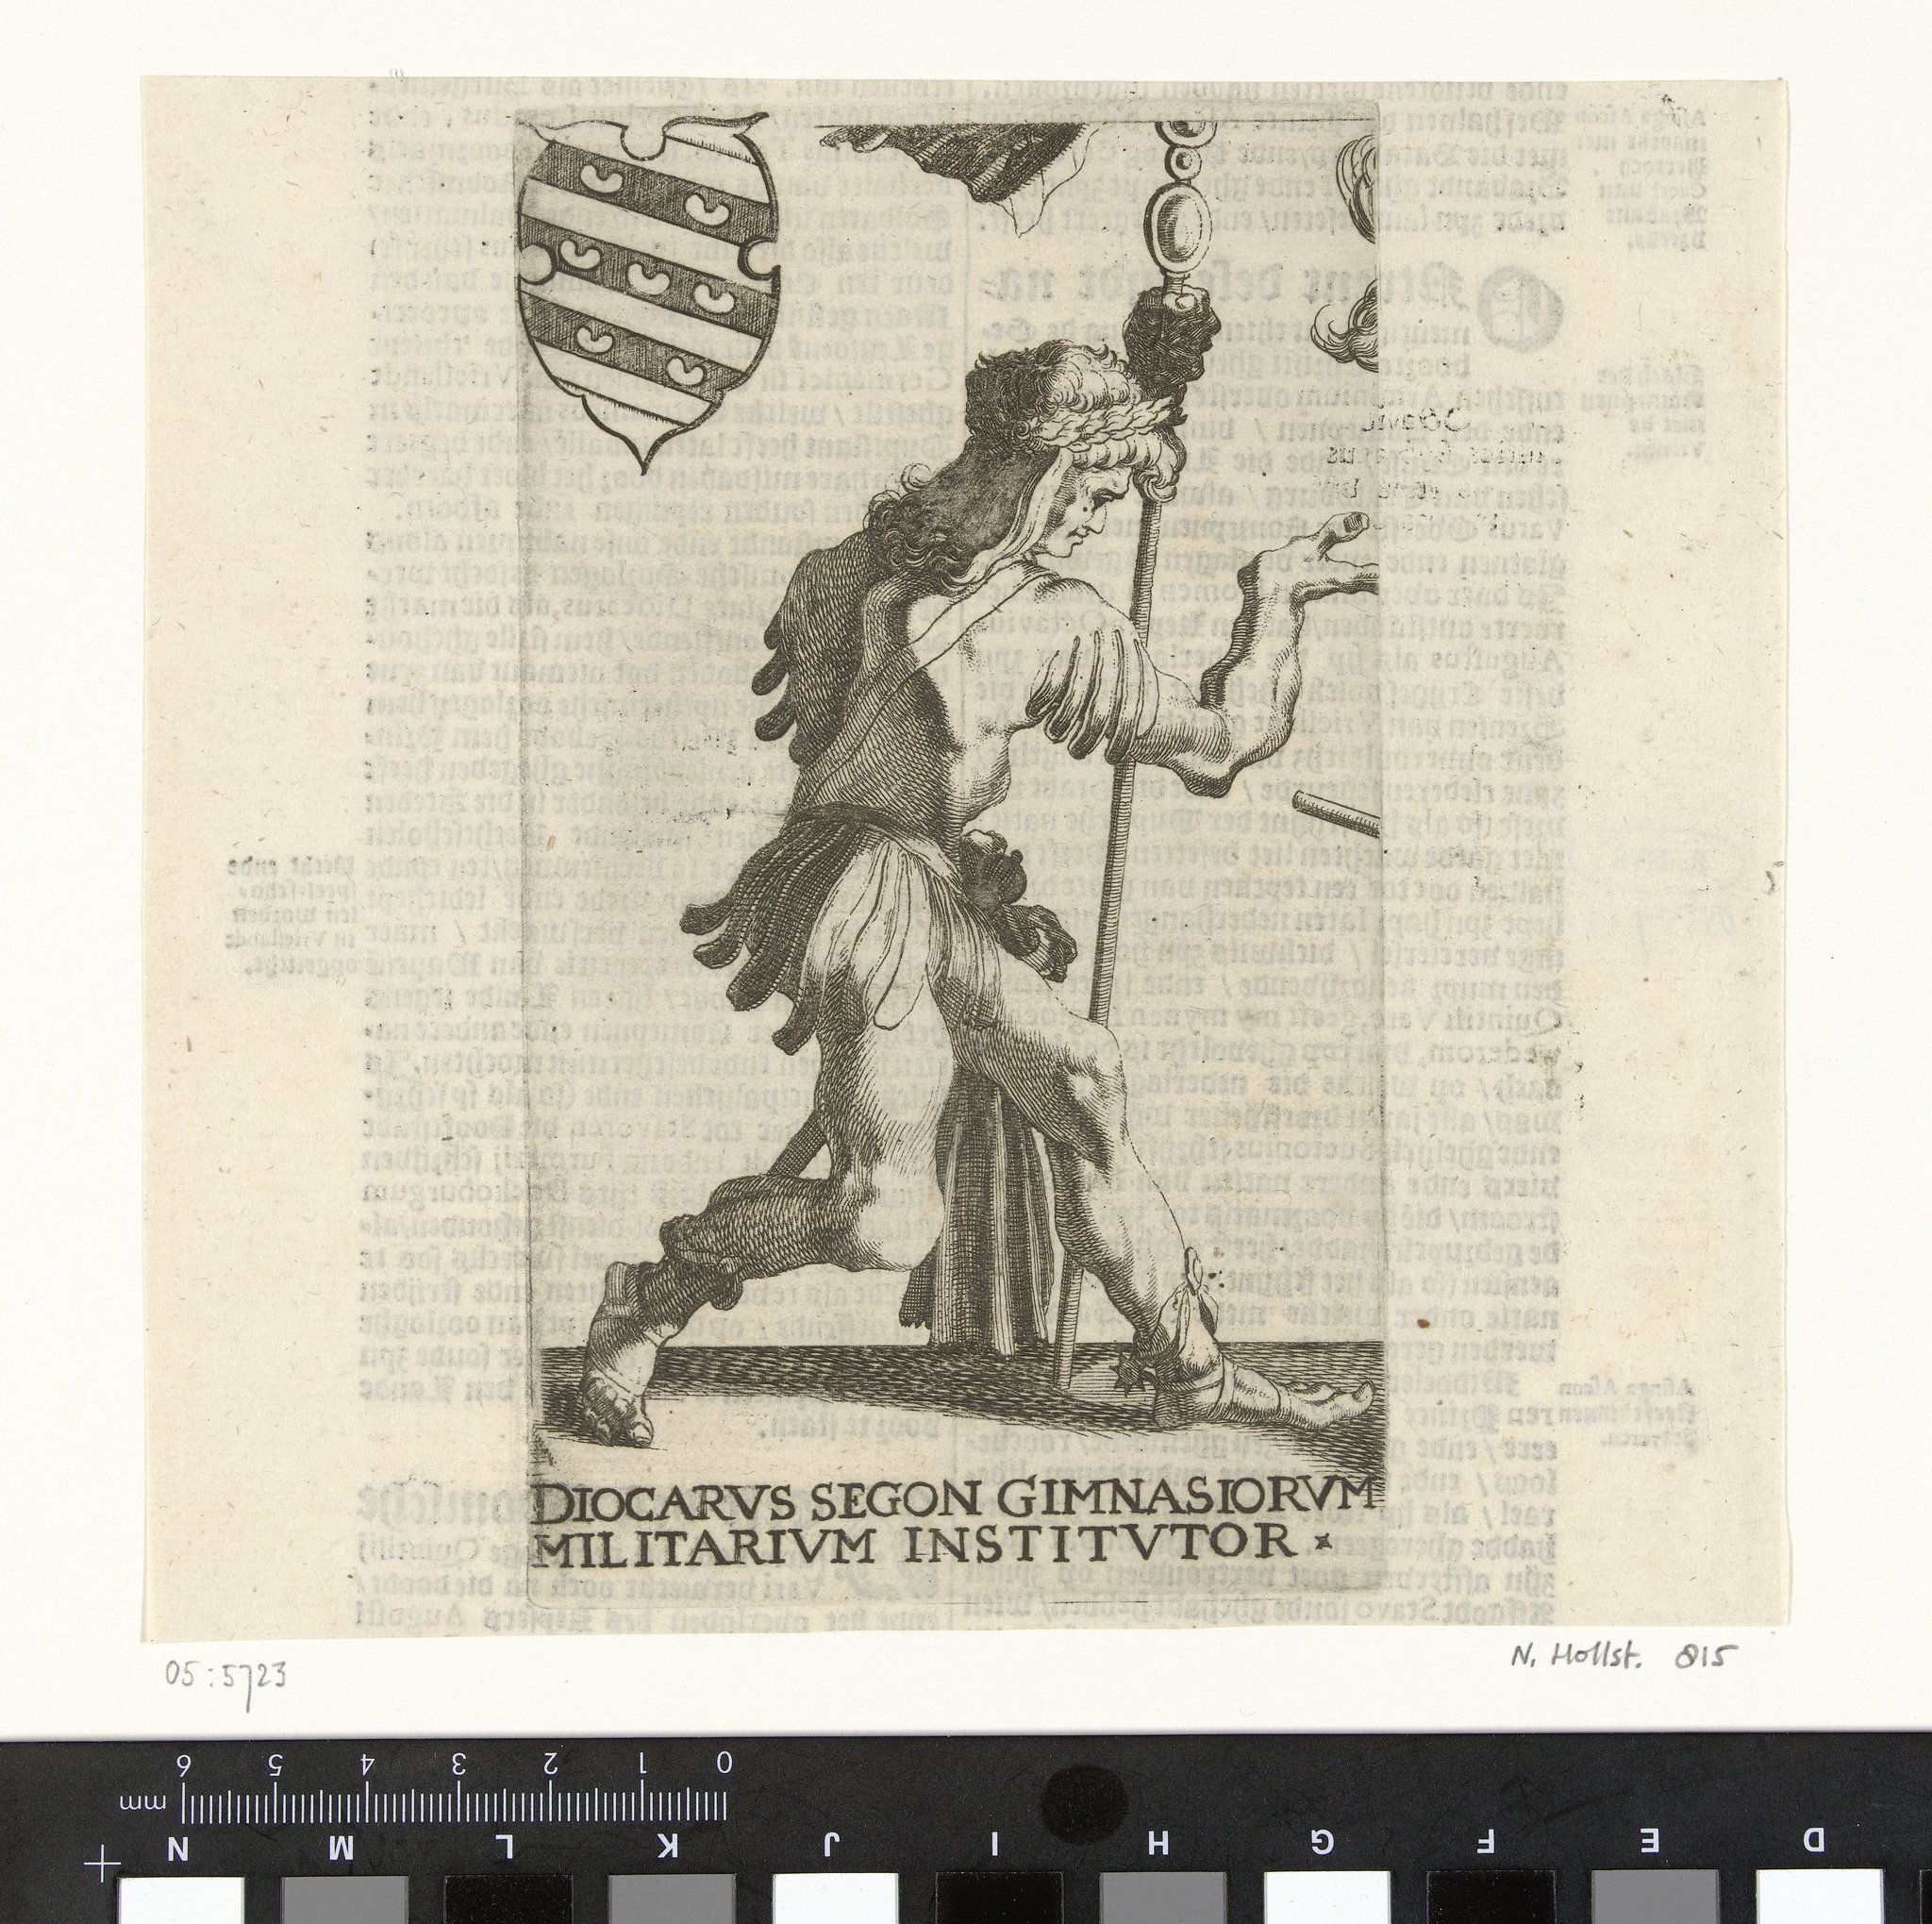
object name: print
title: Diocarus Segon gimnasiorum militarium institutor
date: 1622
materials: paper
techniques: etching, letterpress printing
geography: franeker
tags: diocarus segon (prins der friezen)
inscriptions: collector's mark: Lugt 2228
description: De prent is ook als boekillustratie gebruikt in: Winsemius, P.W. Chronique ofte Historische geschiedenisse van Vrieslant (...). Franeker: Joannes Lamrinck, 1622.